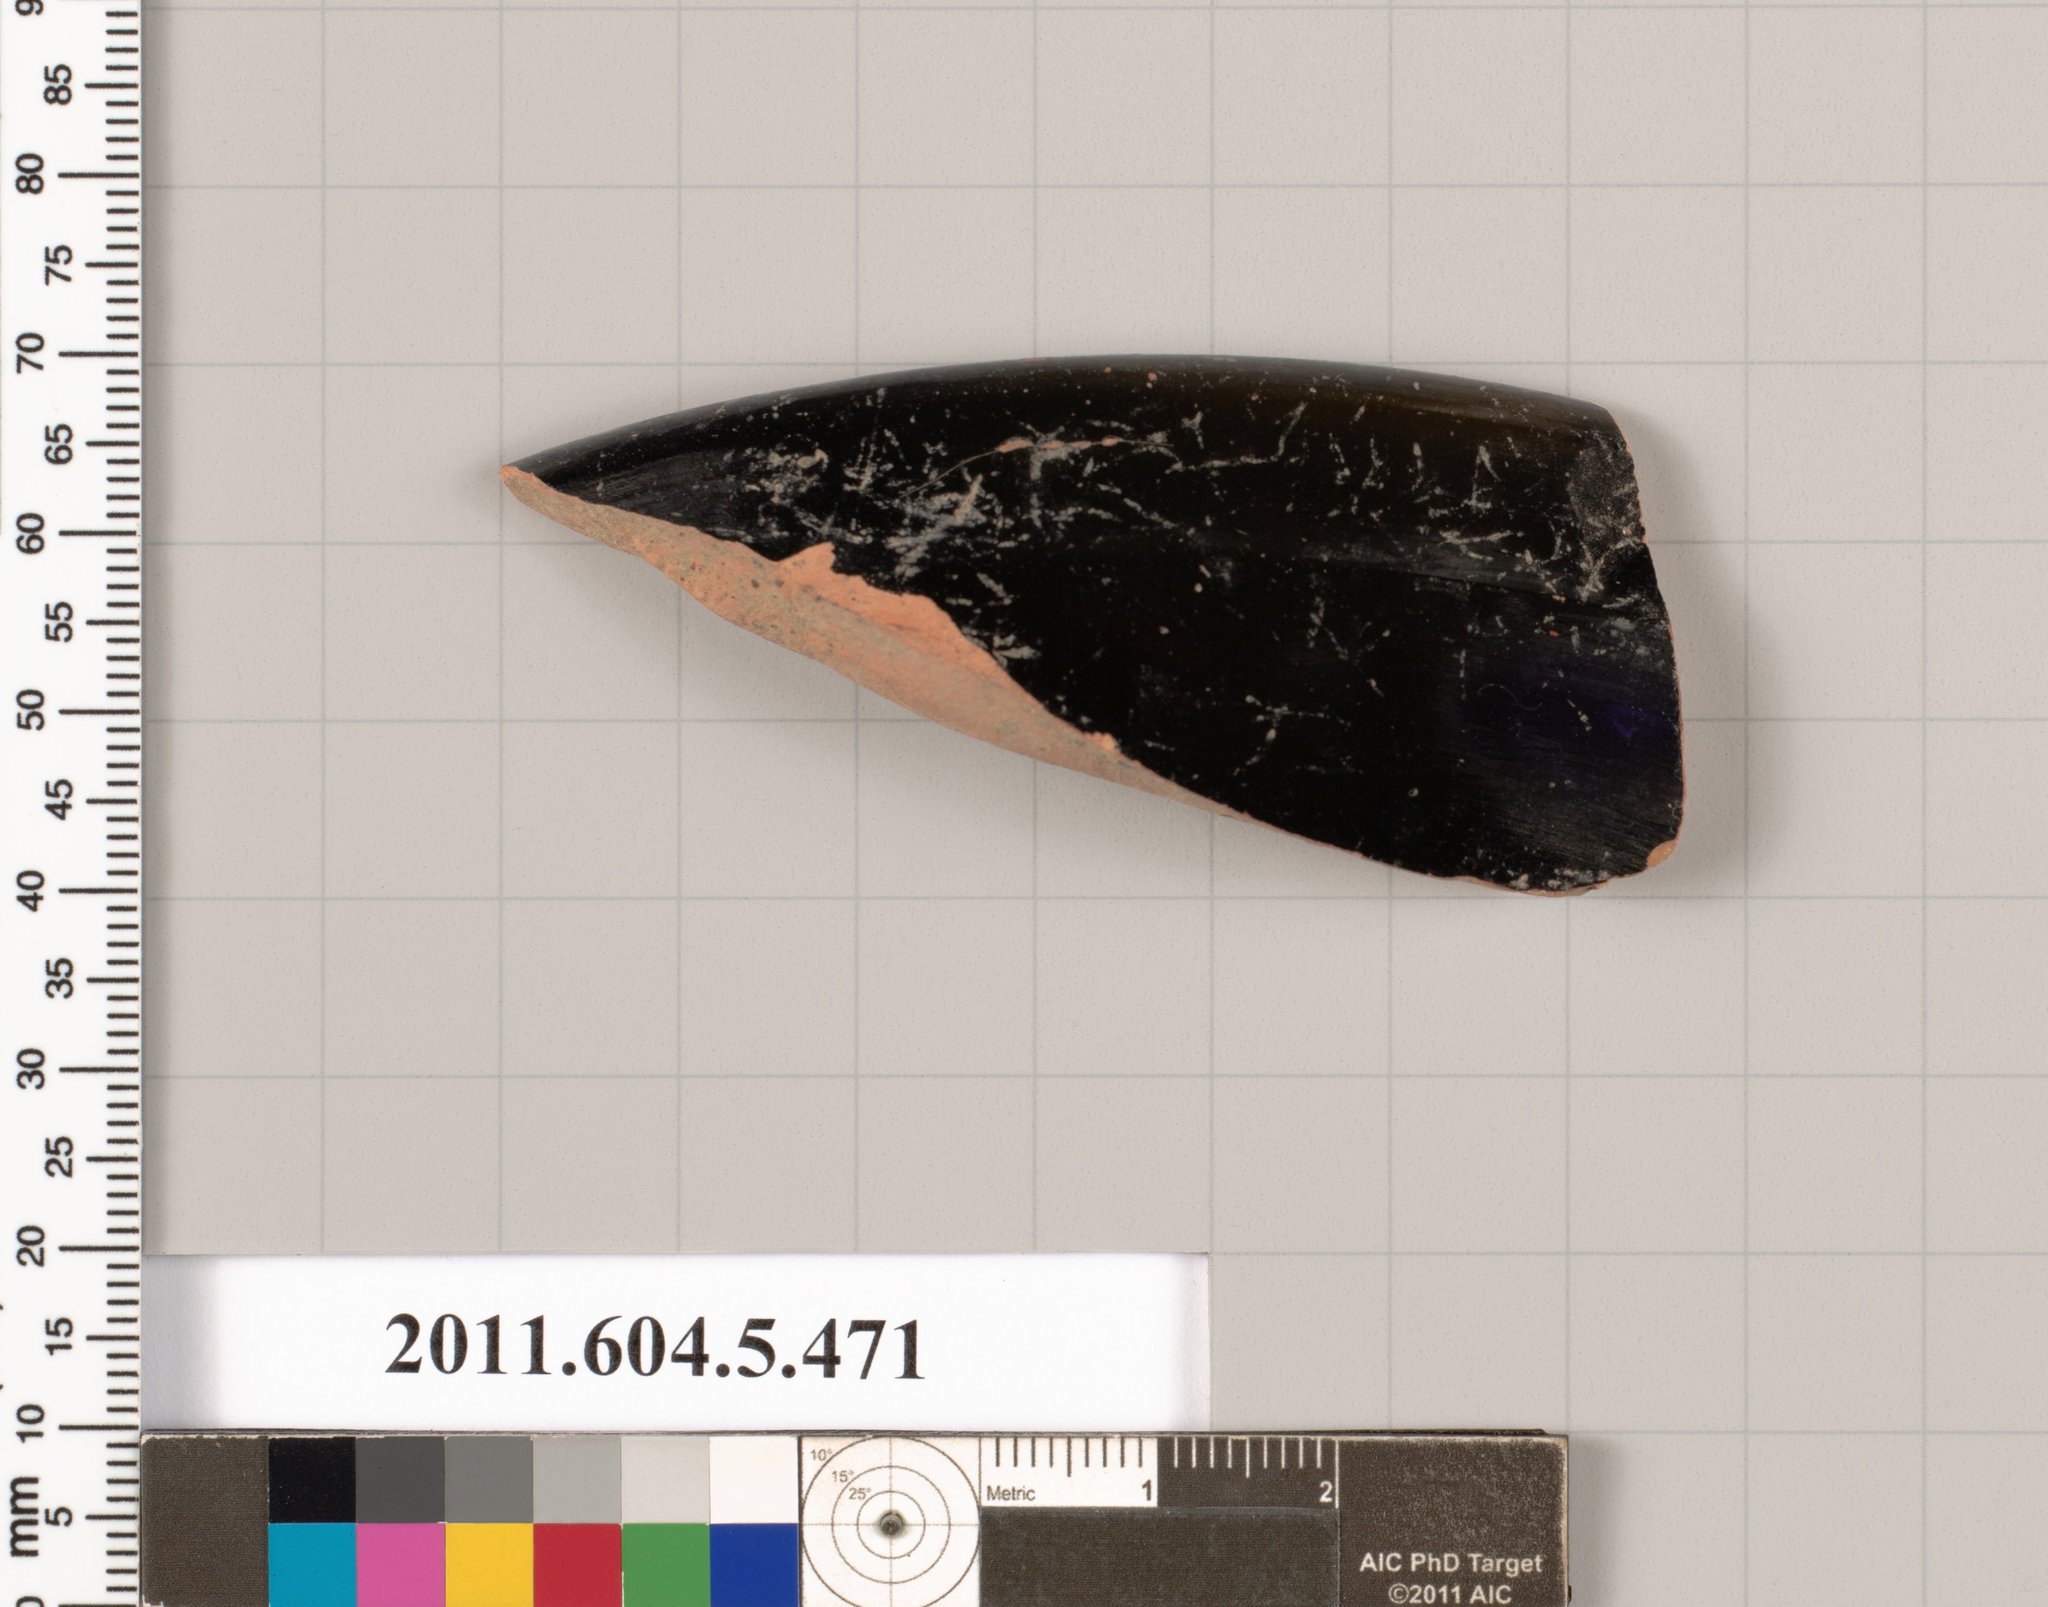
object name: kylix fragment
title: Terracotta rim fragment of a kylix (drinking cup)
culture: greek, attic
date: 600-401 BCE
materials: terracotta